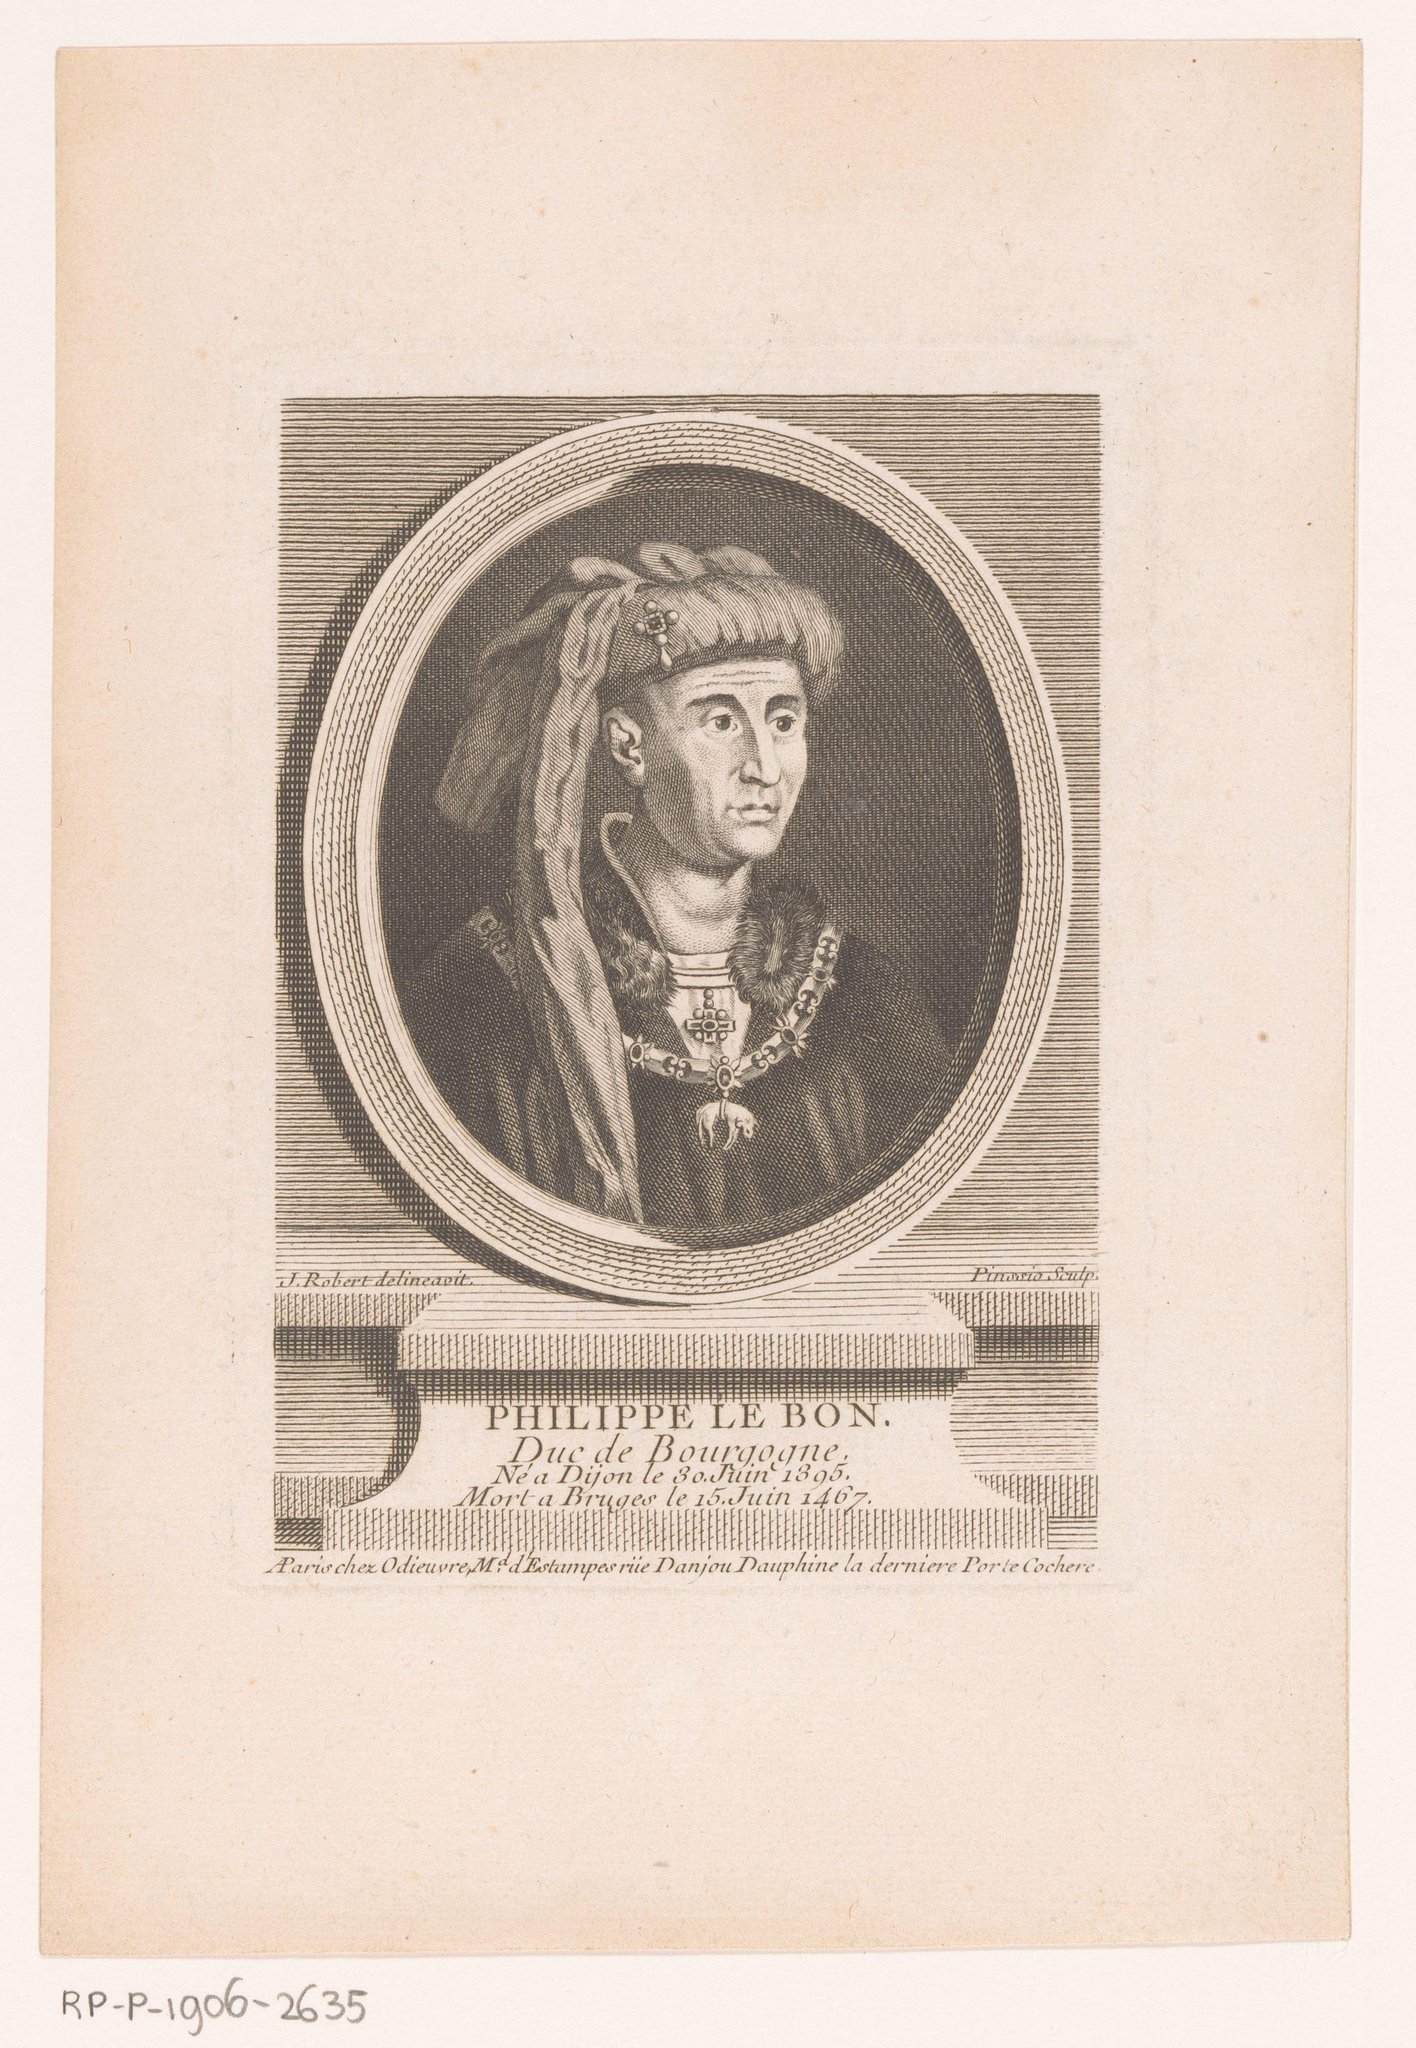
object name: book illustration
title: Portret van Filips de Goede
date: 1755-1765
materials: paper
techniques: engraving, etching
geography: paris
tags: bruges, philip iii the good, historical persons, nobility and patriciate; chivalry, knighthood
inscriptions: collector's mark: Lugt 2228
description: Prent uit: Dreux du Radier, Jean-François. L'Europe illustré, contenant l'histoire abregée des souverains, des princes, des prélats, des ministres, (...) en Europe: dans le XVe. siècle compris, jusqu'à présent. Parijs: Michel Odieuvre en André-François Le Breton, 1755-1765.